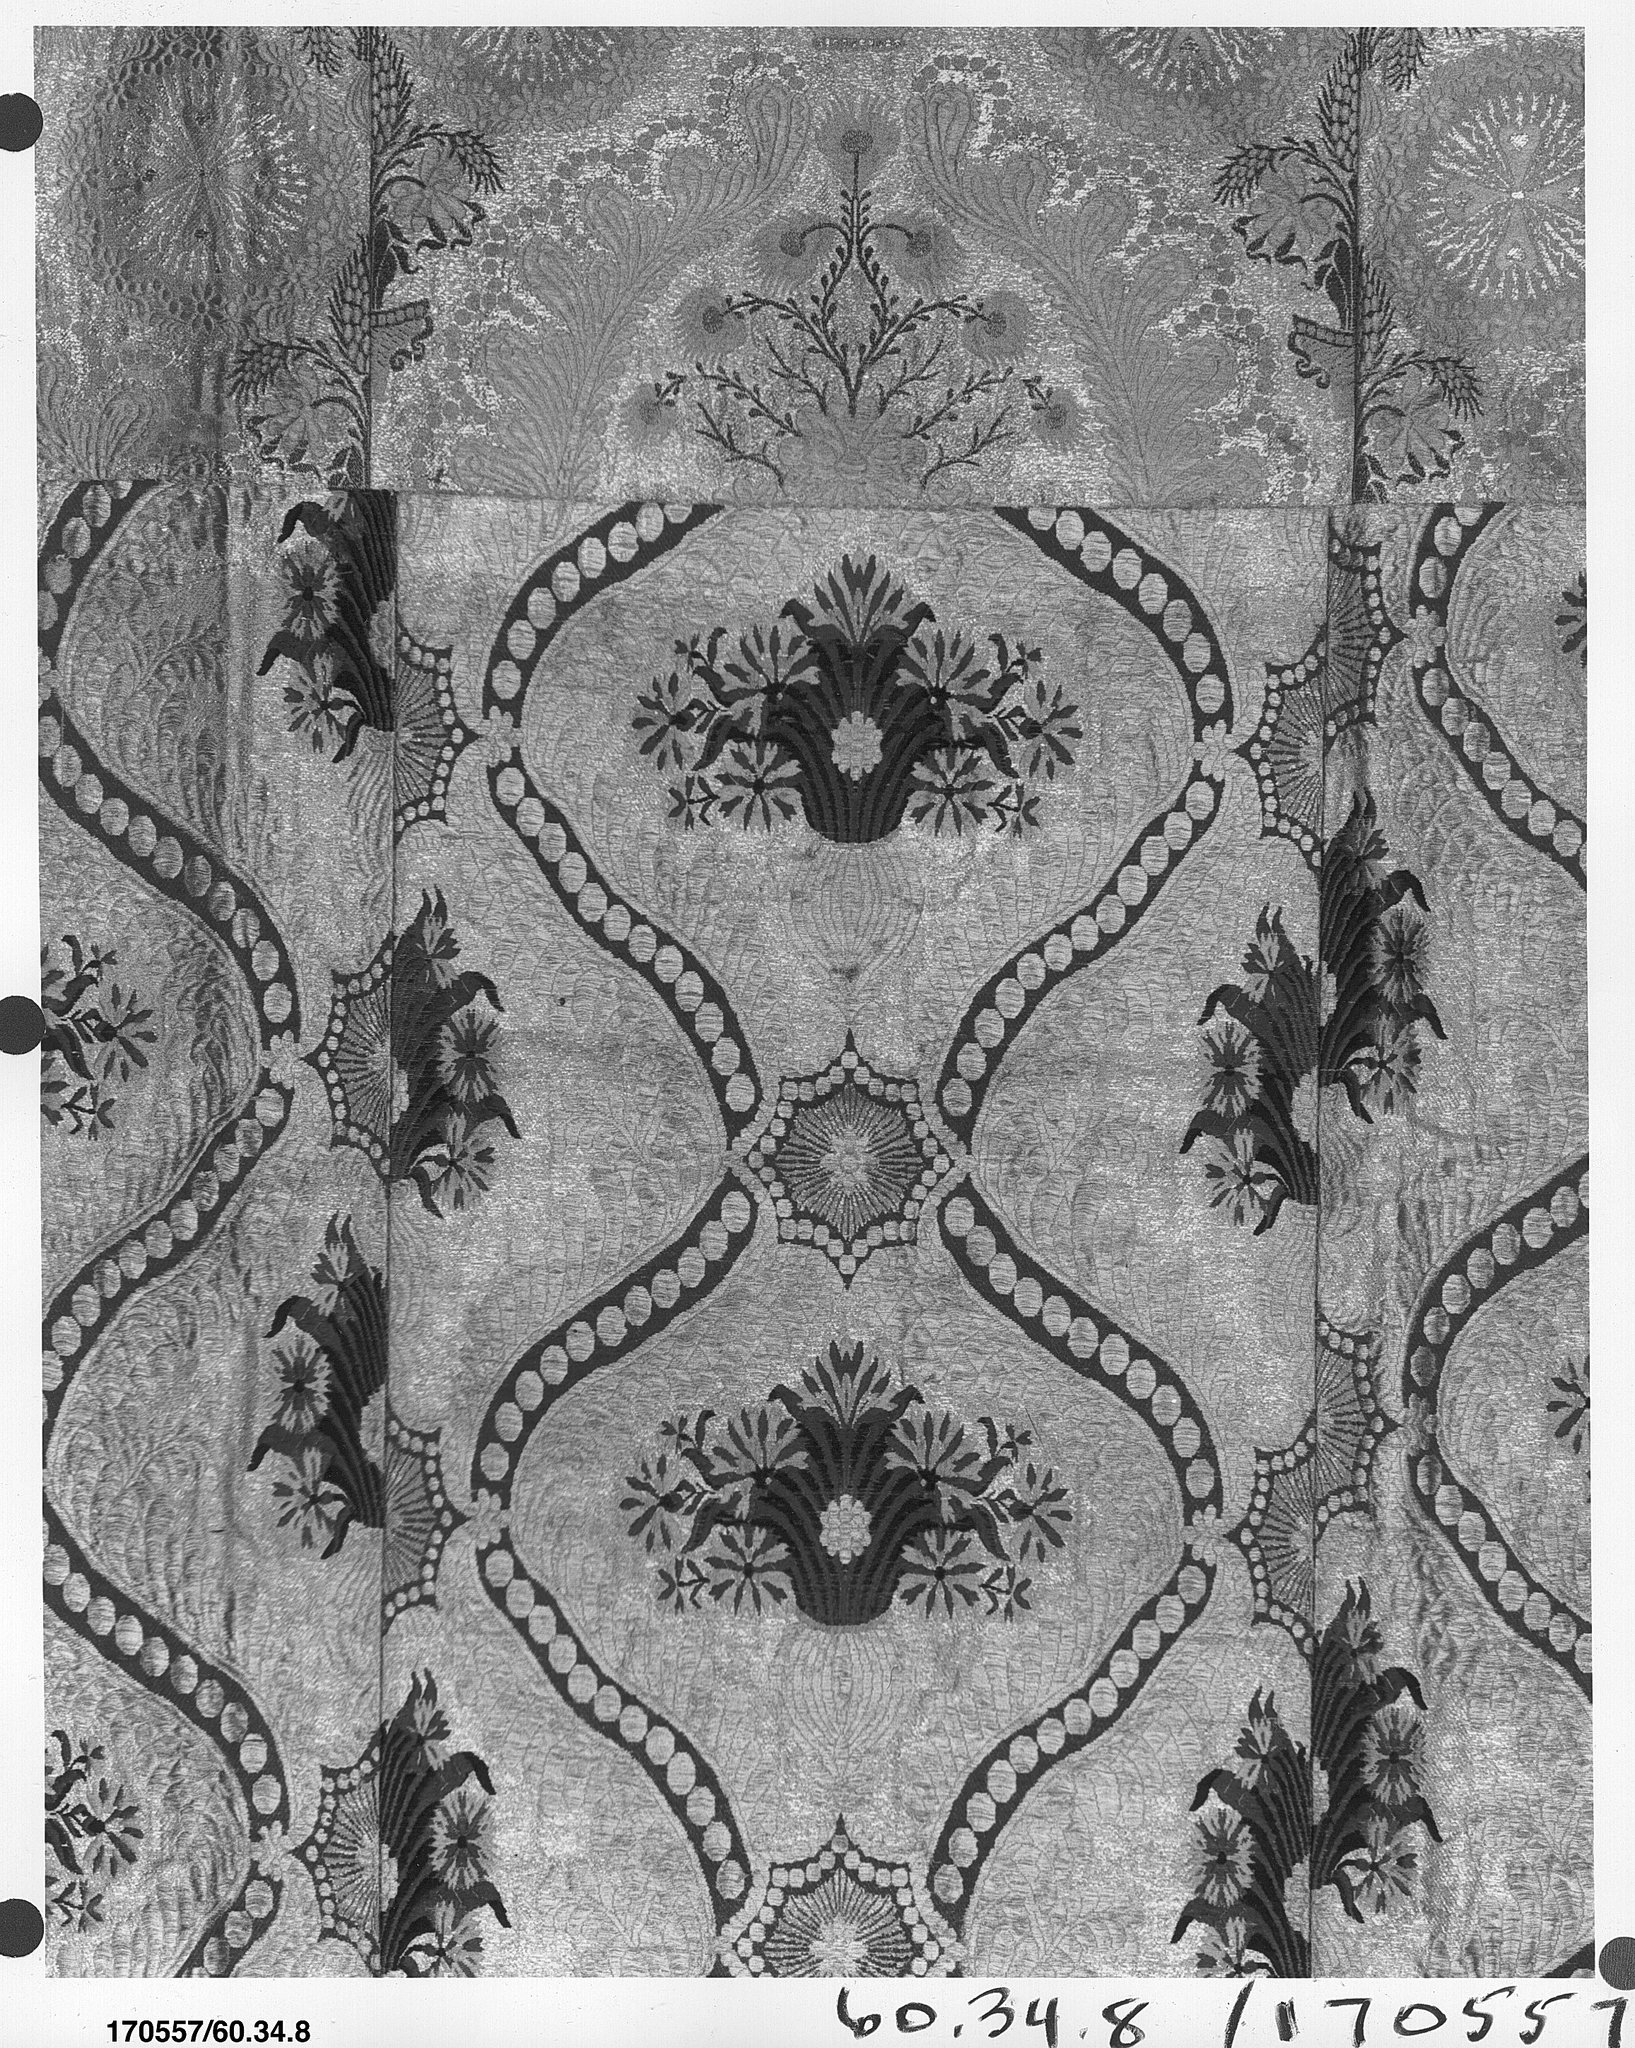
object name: piece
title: Pieces (2)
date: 1801-1900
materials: cotton, metal thread, silk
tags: leaves